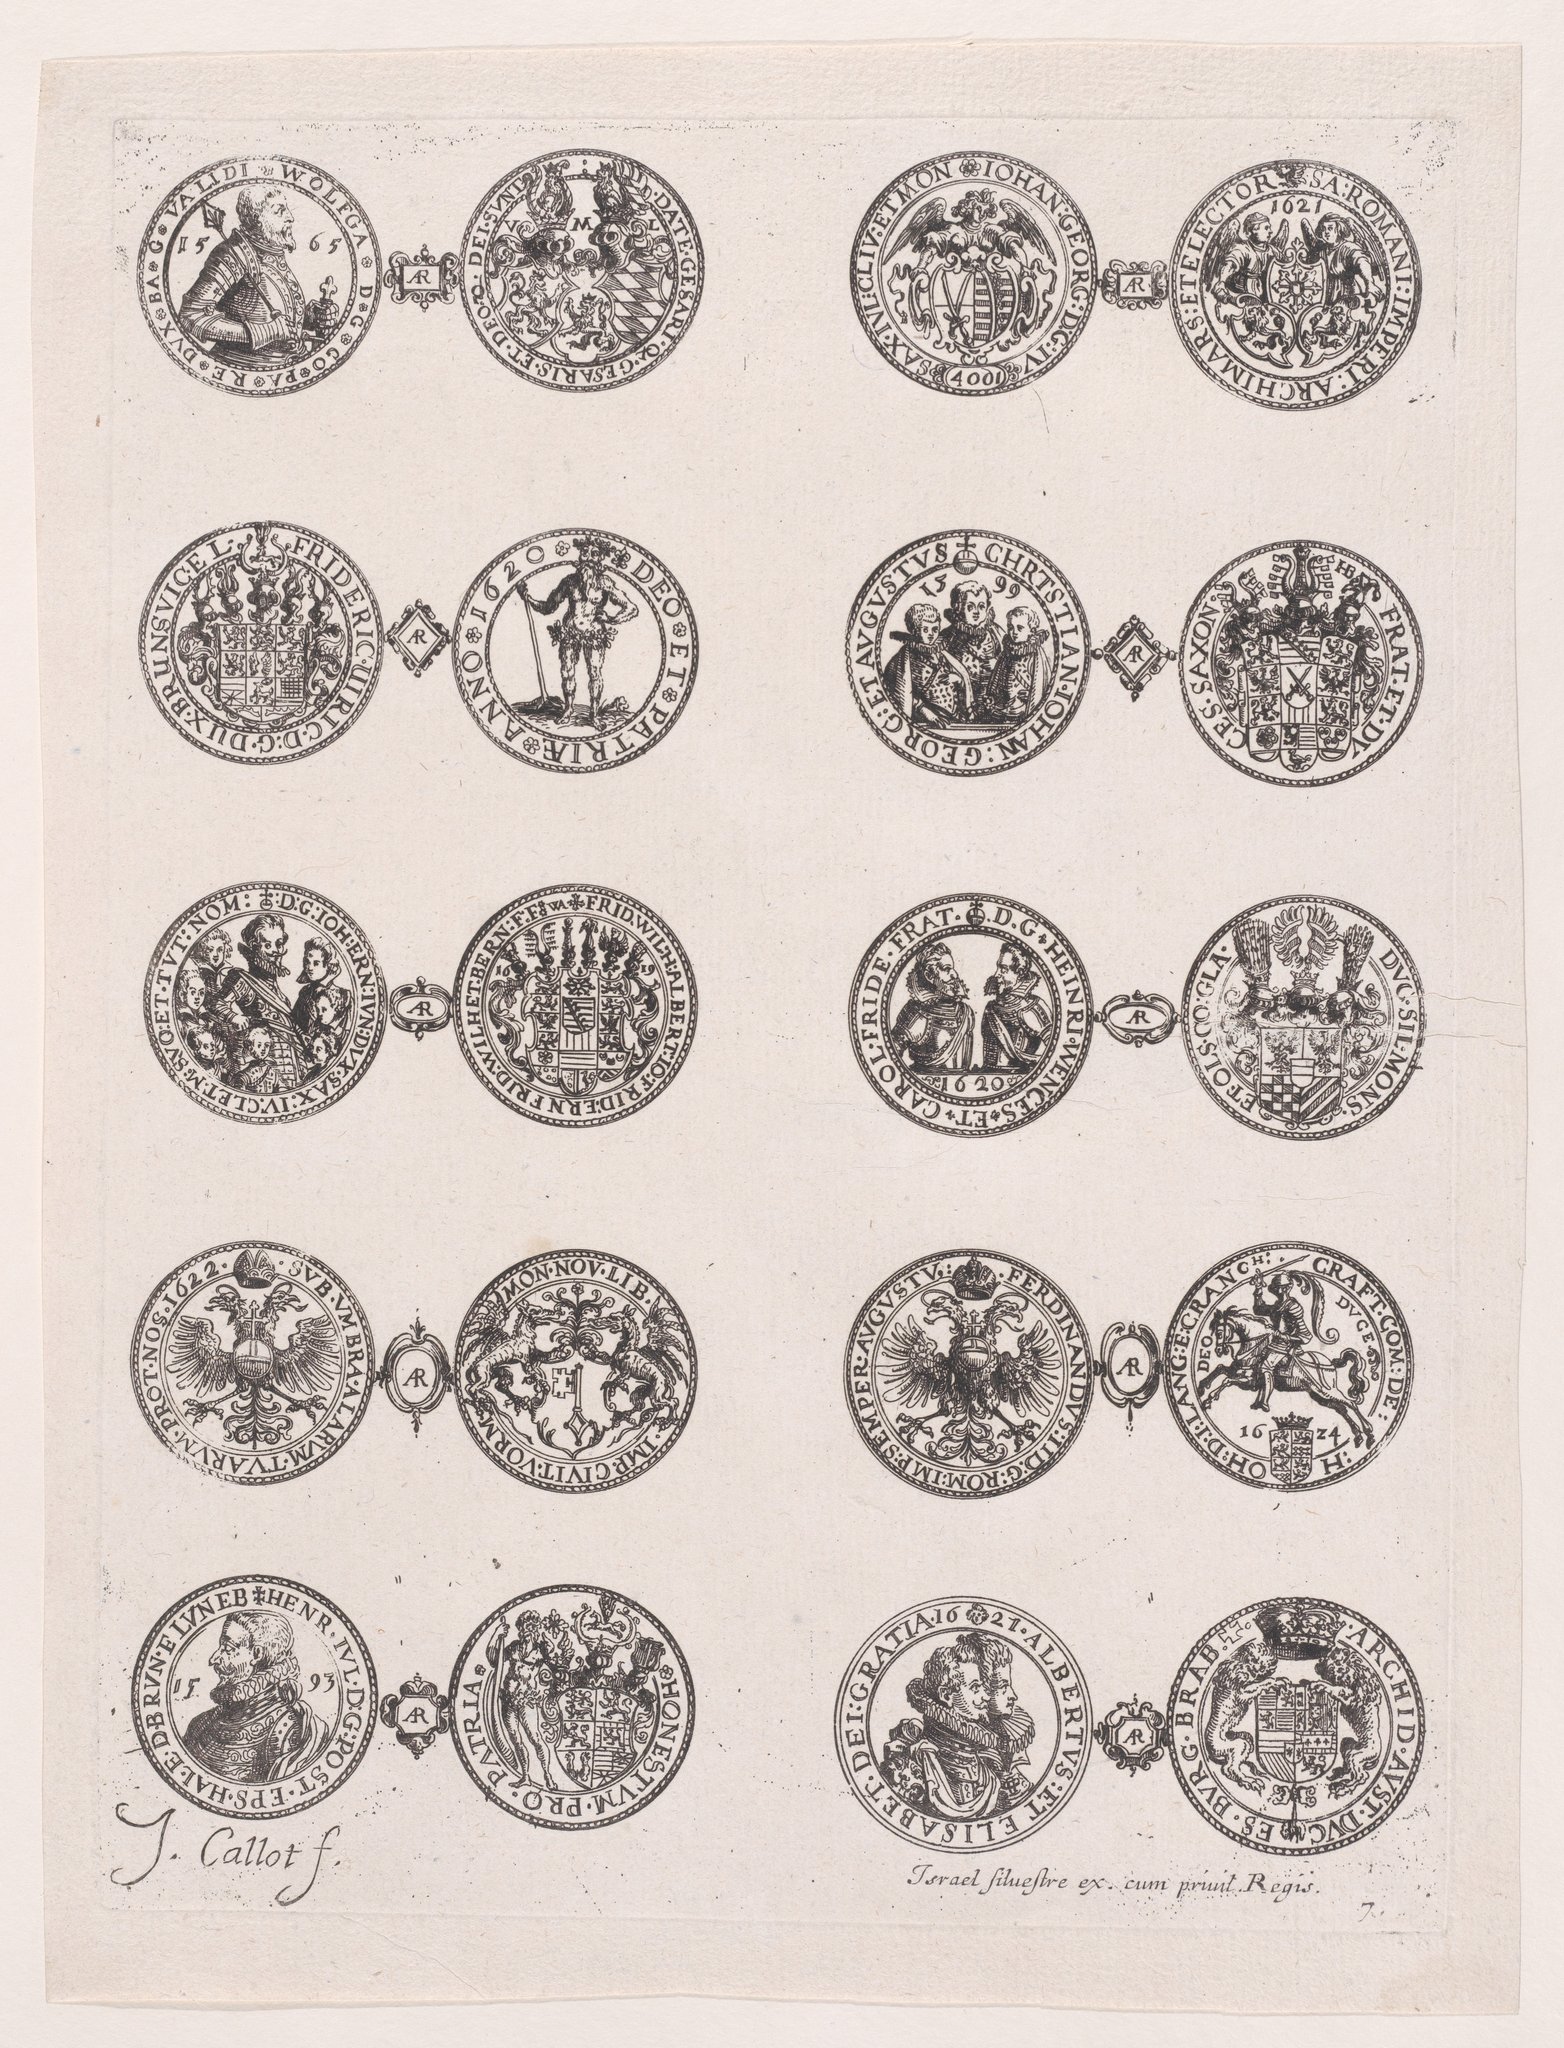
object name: print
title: Plate 7, Featuring 10 Coins Issued by European Princes in the 16th and 17th centuries, from "Les Monnaies" (The Currencies)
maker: jacques callot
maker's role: artist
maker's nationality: french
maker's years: 1592-1635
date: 1630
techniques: etching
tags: coins